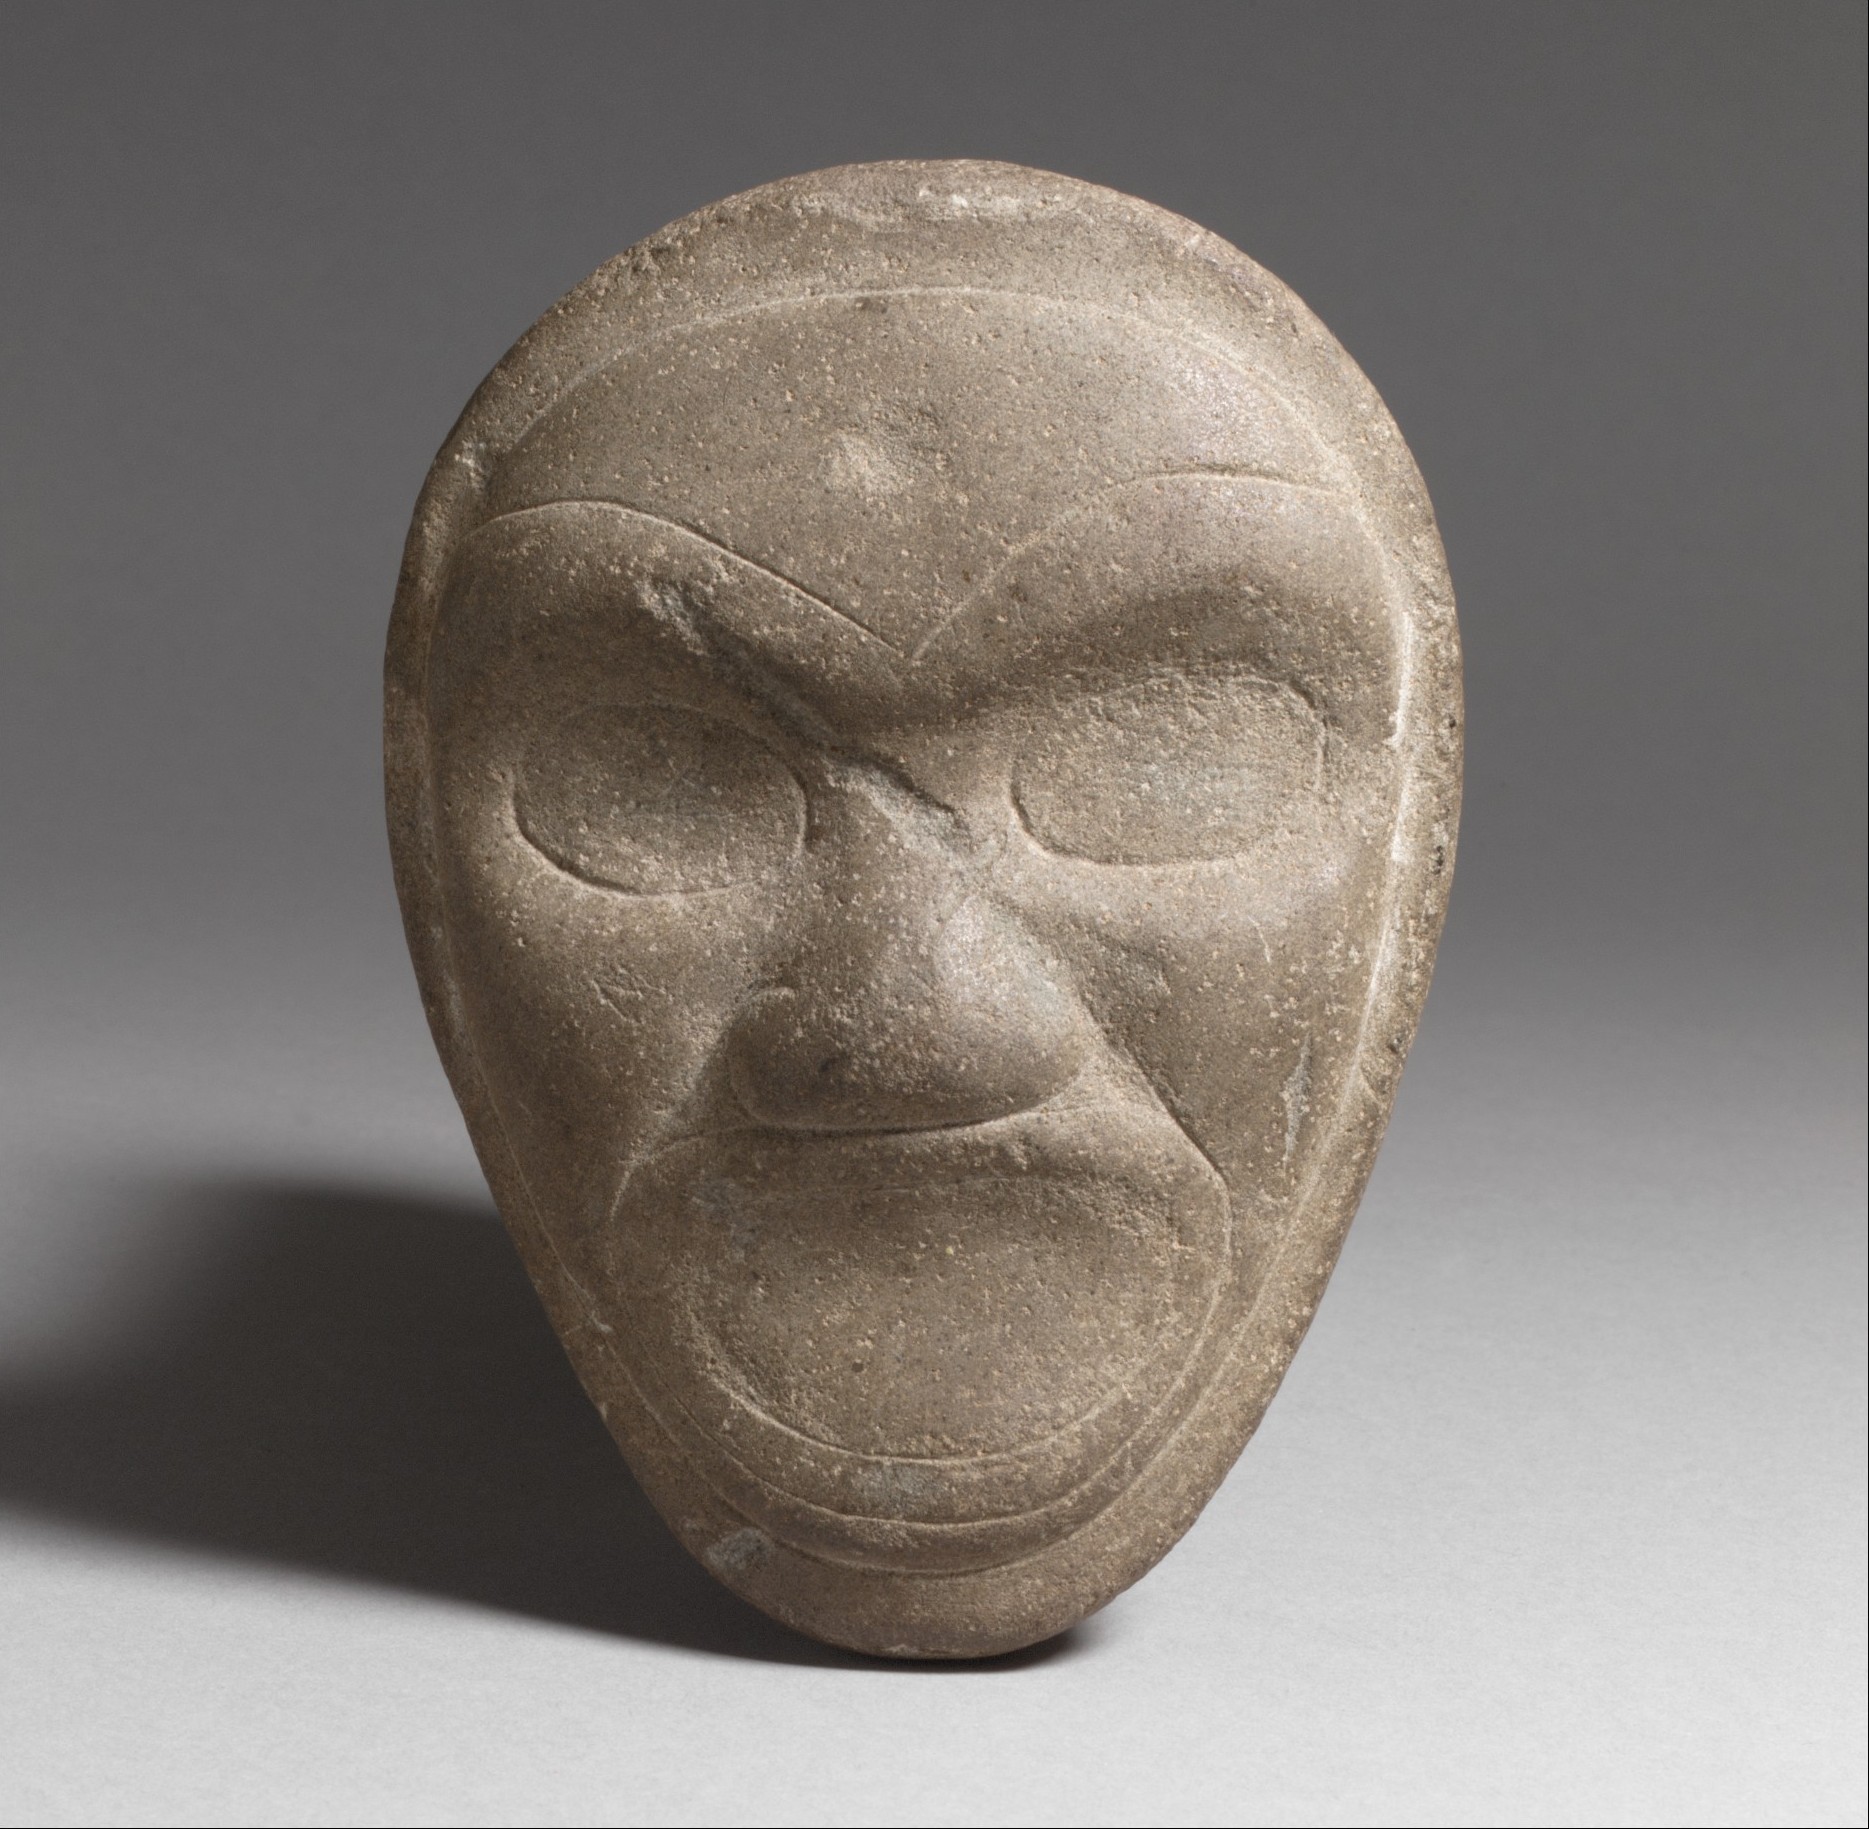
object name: head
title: Guaíza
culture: taíno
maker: taíno artist(s)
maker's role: artist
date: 1200-1500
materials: stone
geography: puerto rico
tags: heads